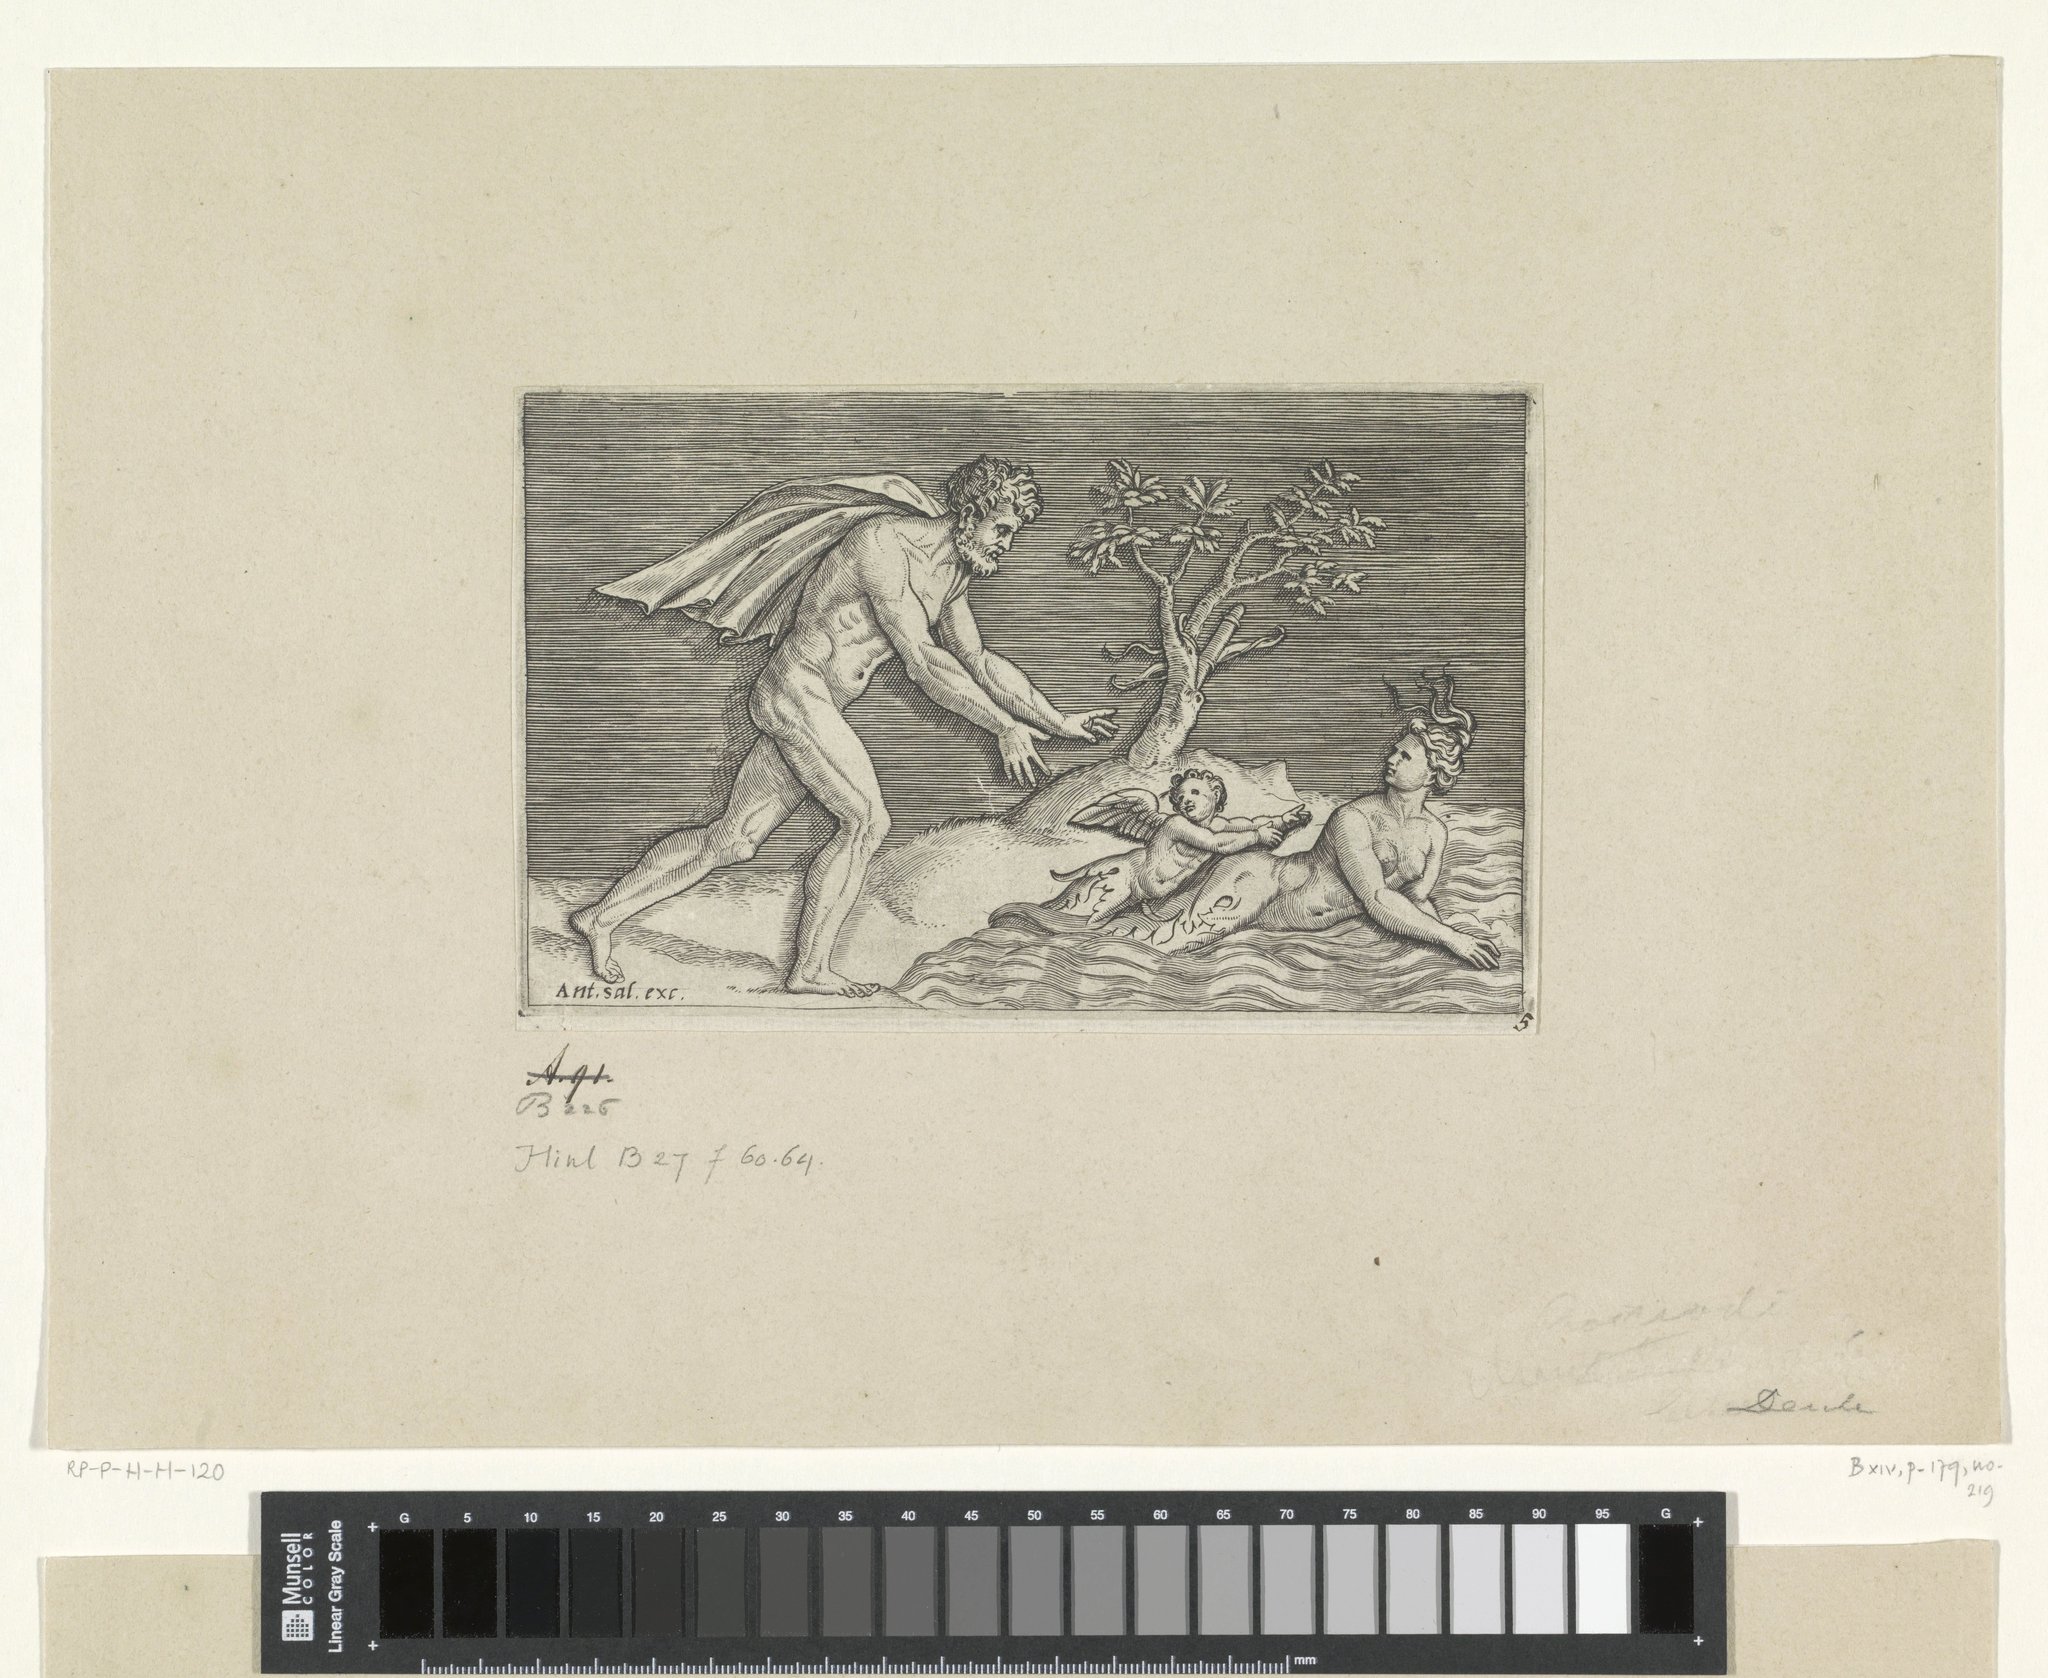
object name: print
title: Naakte man achtervolgt een Naiade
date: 1517-1562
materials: paper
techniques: engraving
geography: italy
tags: naiads, river- and spring-nymphs; usually carrying an urn; 'naiadi, ninfe de' fiumi' (ripa)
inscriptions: collector's mark: Lugt 10, collector's mark: ‘Hinloopen’, collector's mark: Lugt 11, number: ‘5’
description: Een naakte man met een cape achtervolgt een vluchtende Naiade en een jonge gevleugelde Naiade. Op de achtergrond een boom.